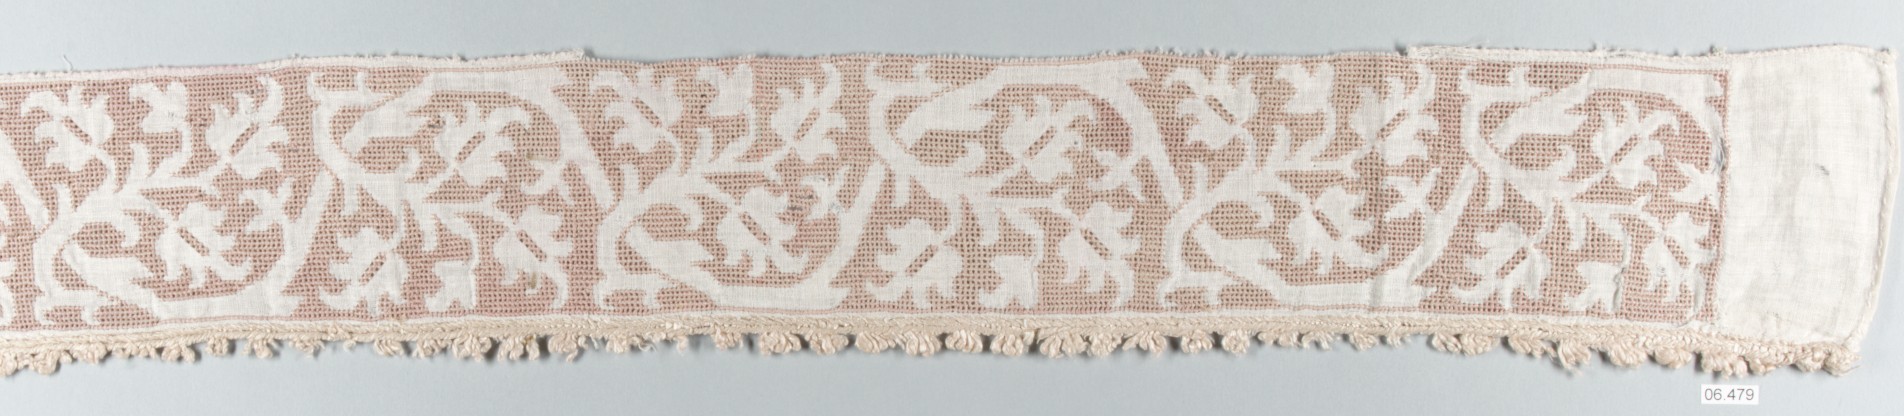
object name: border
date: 1501-1600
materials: linen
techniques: embroidery